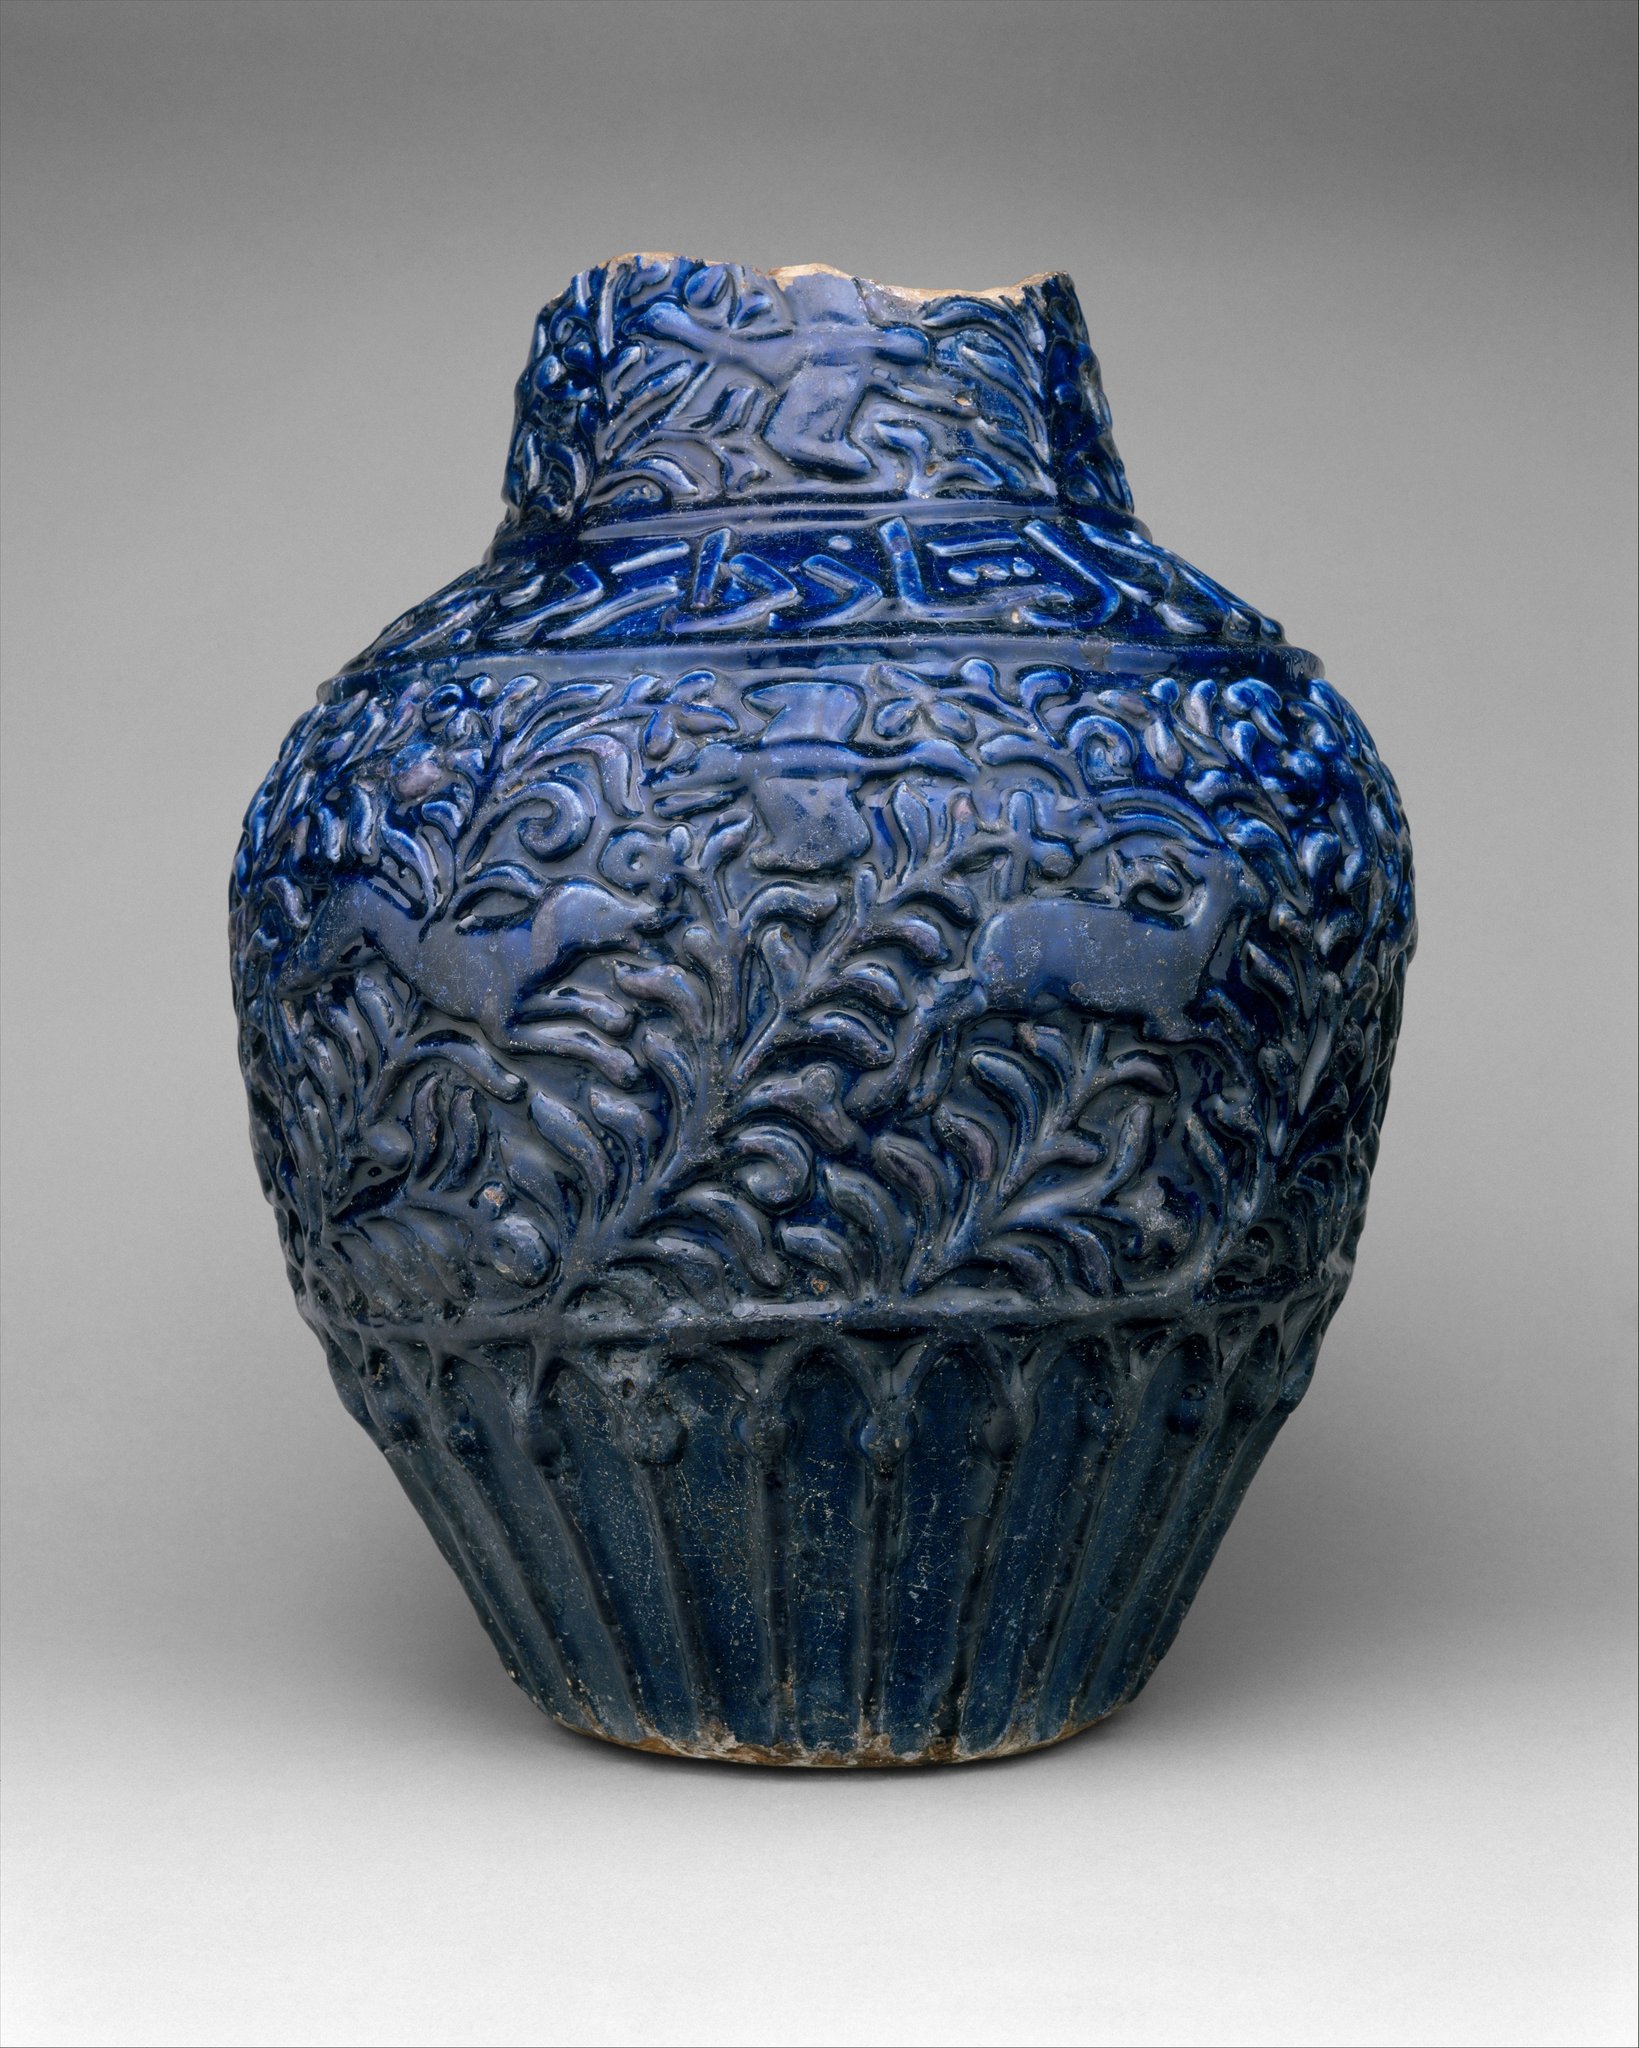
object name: jar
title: Large Jar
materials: stonepaste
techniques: glazing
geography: iran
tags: animals,birds